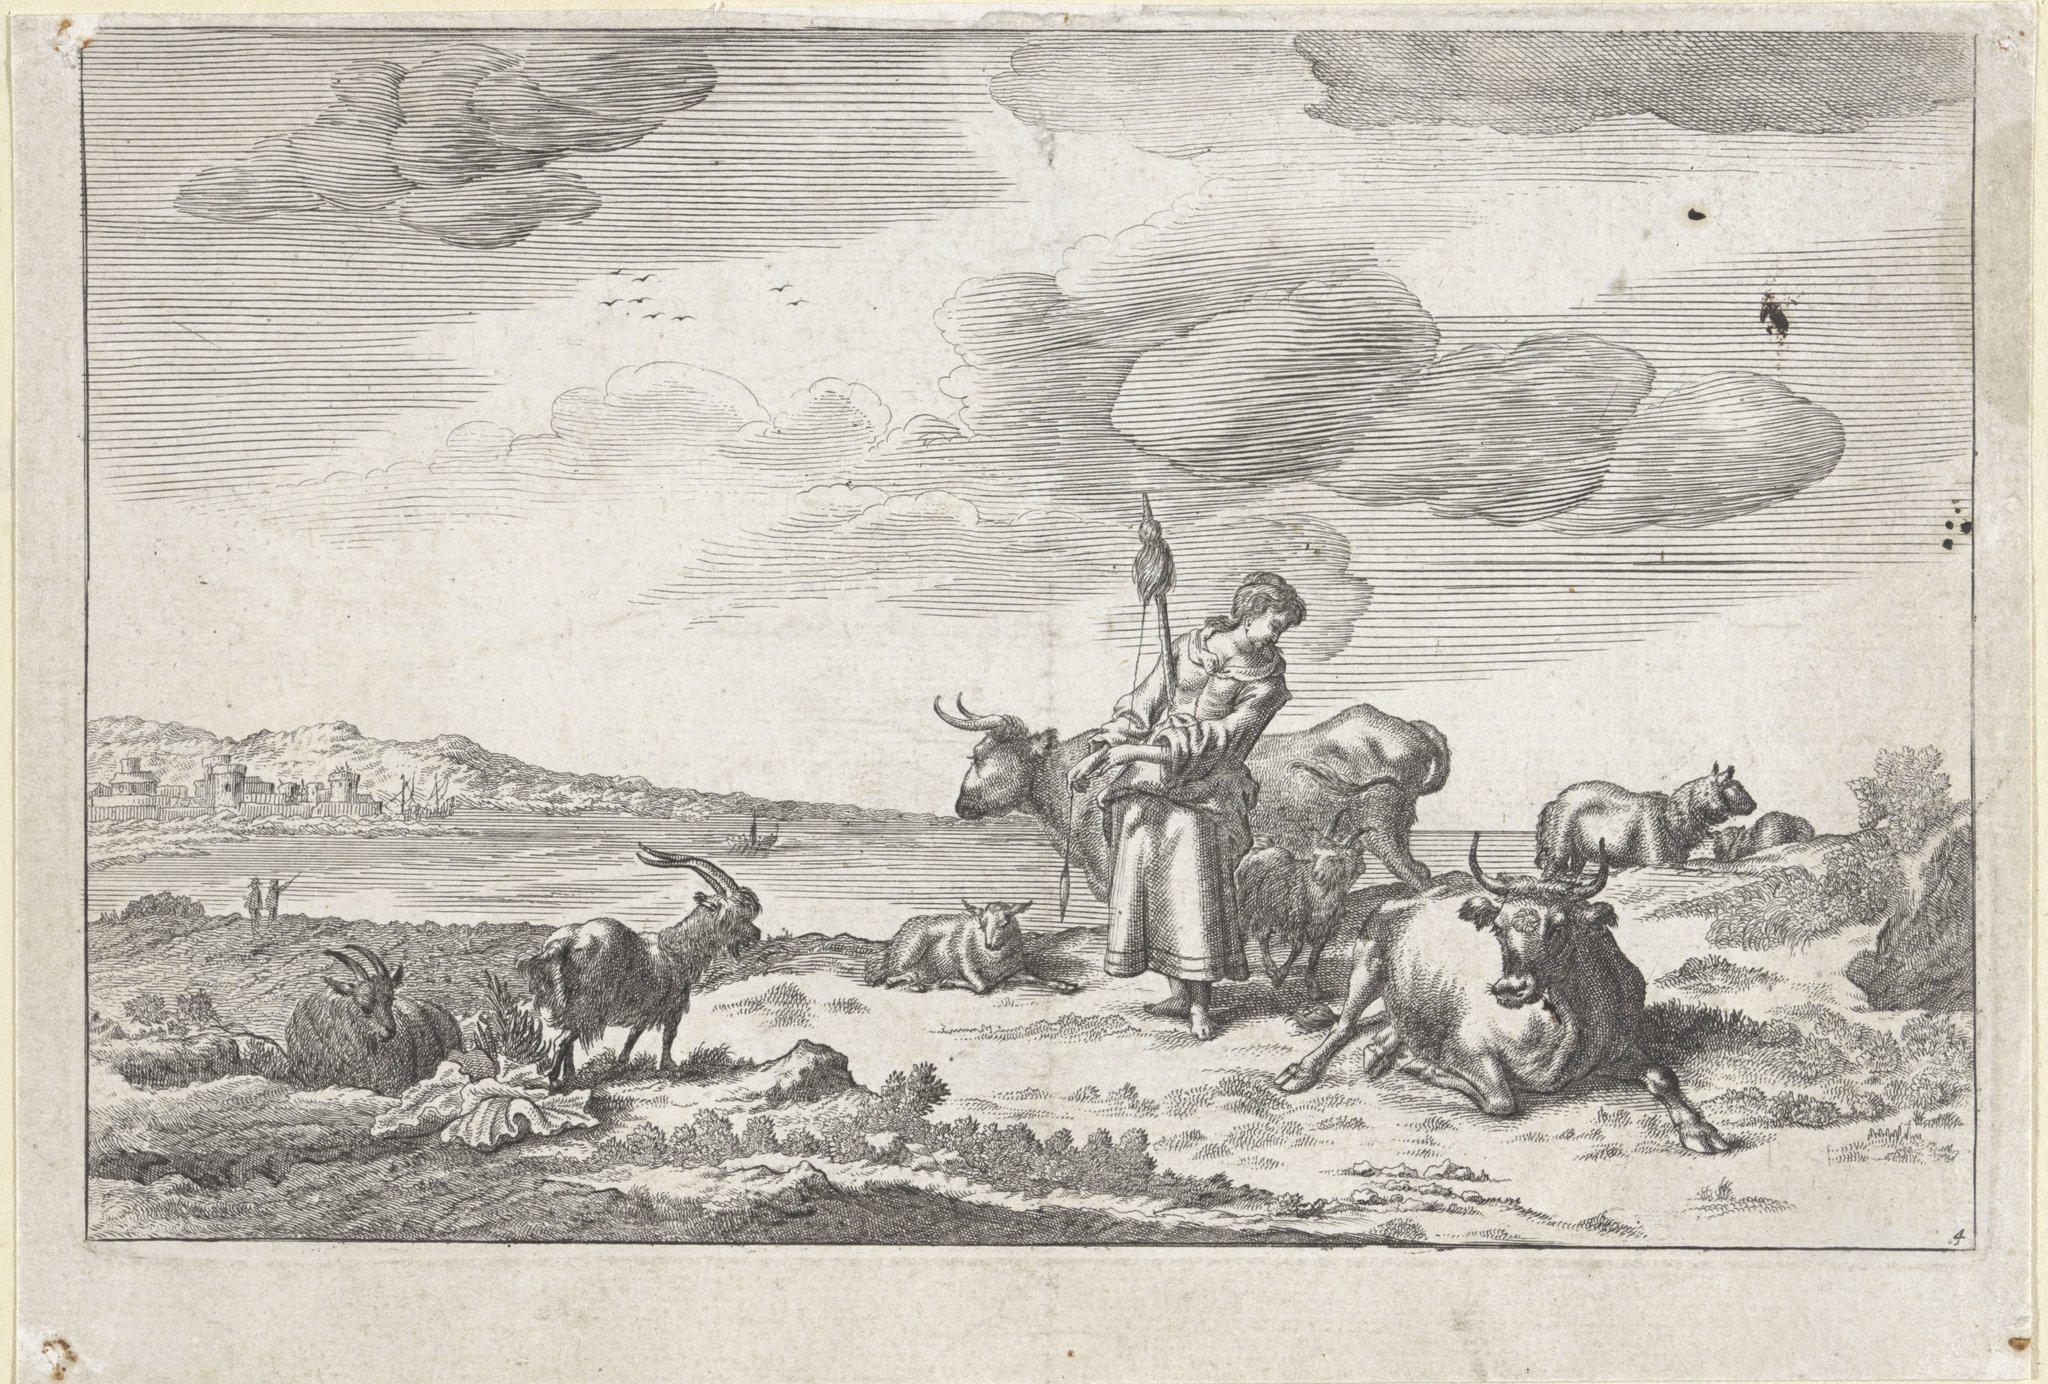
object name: print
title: Herderin met spintol aan de oever van een rivier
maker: Anonymous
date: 1643-1742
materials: paper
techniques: engraving, etching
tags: cow, sailing-ship, sailing-boat, river, herding, herdsman, herdswoman, shepherd, shepherdess, cowherd, etc., spindle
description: Aan de oever van een brede rivier staat een herderin met een spintol temidden van het vee. Op de achtergrond een dorp met haven en een schip op de rivier.